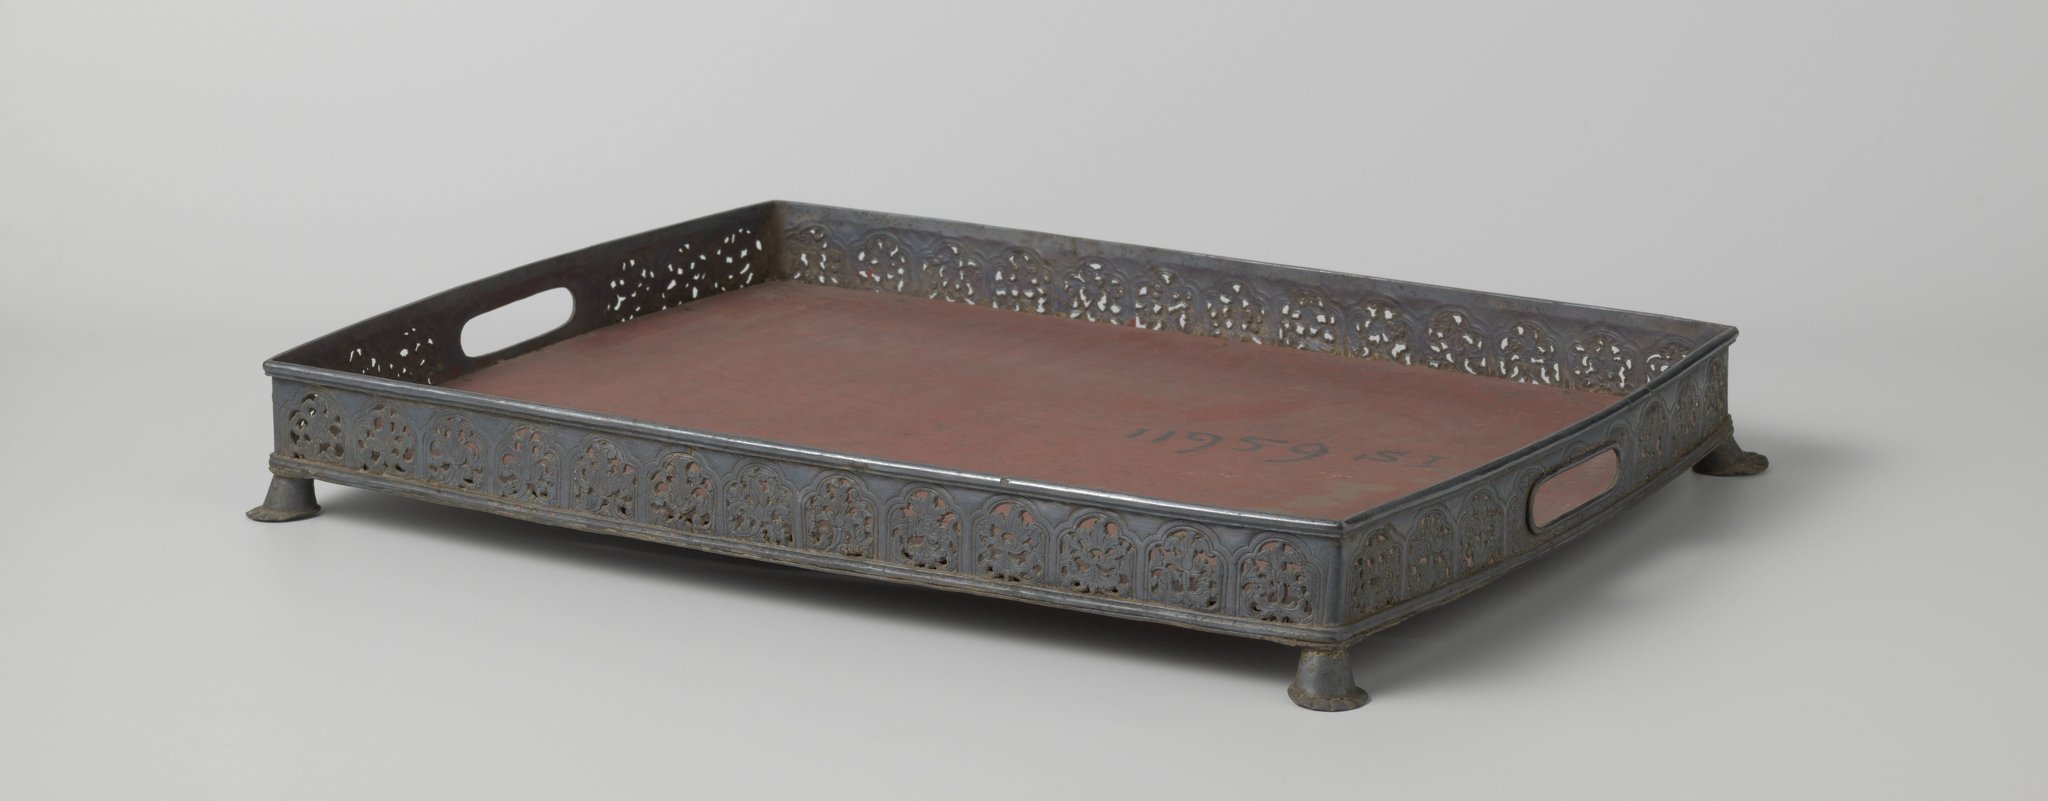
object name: tea tray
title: Theeblad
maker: Anonymous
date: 1700-1900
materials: silver, wood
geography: indonesia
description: Theeblad van teakhout met een zilveren opstaande en opengewerkte rand, op de hoeken verbonden met licht uitstaande voeten. De wand bestaat uit een aaneenschakeling van opengewerkte, aan de bovenzijde gelobde 'nissen' met opengewerkte bloeiende planten.